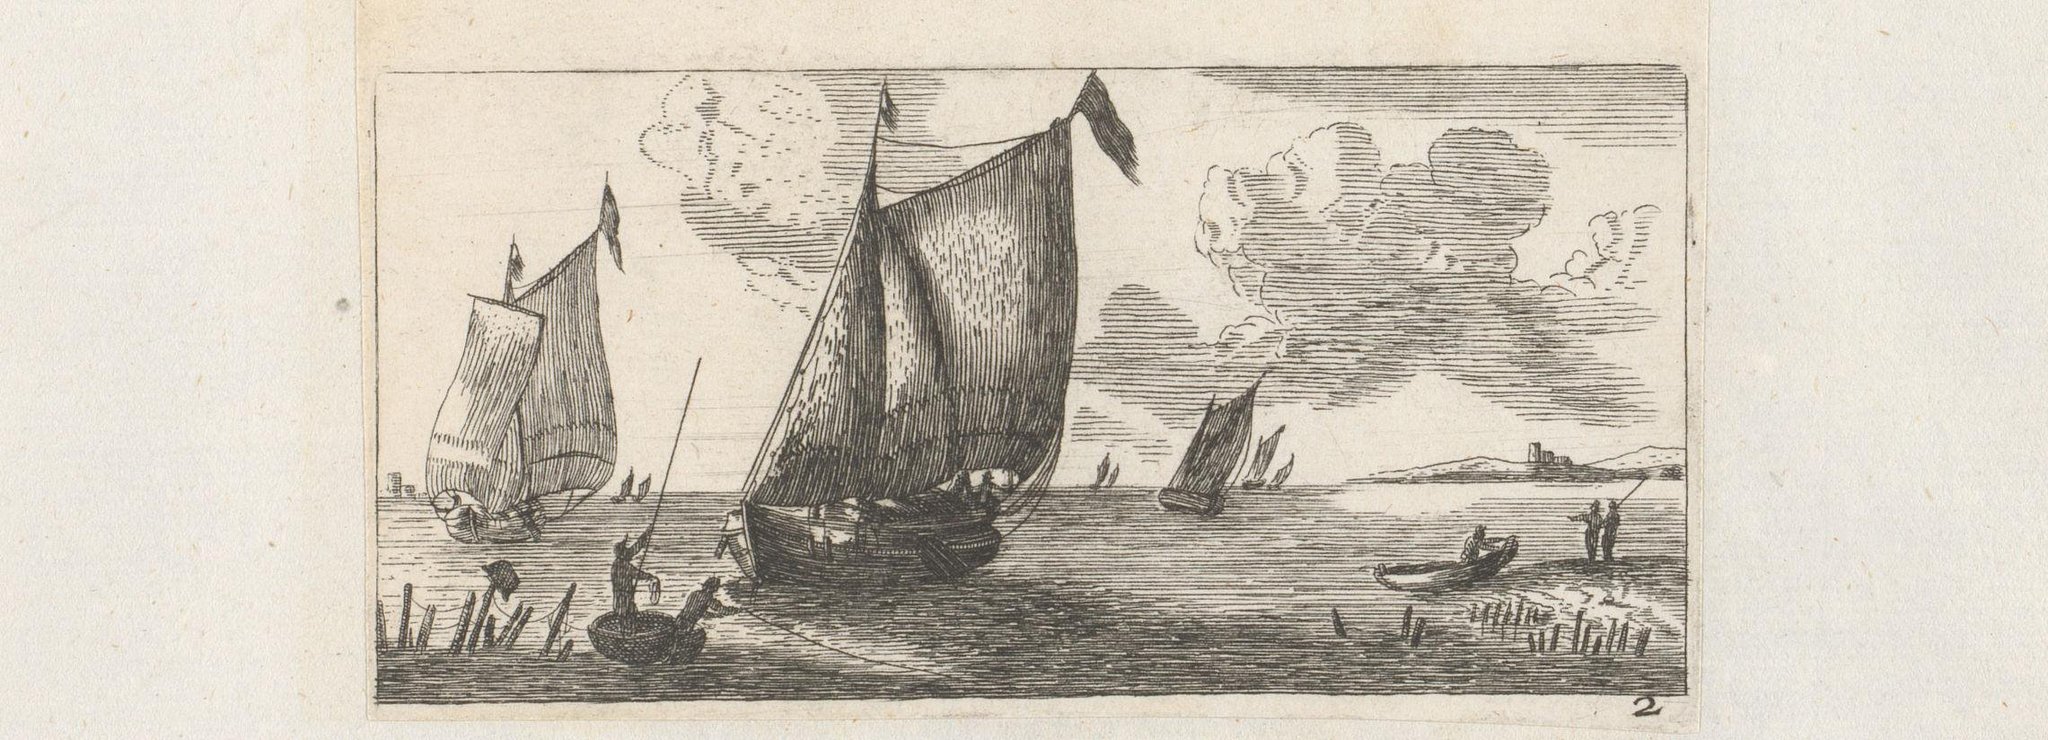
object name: print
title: Zeilschepen en vissers aan de kust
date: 1686-1724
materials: paper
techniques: etching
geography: augsburg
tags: sailing-ship, sailing-boat, coast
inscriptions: collector's mark: Lugt 2228, collector's mark: Lugt 2760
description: Prent uit een reeks met soortgelijke zeegezichten. Het is onbekend uit hoeveel prenten deze serie in totaal bestaat. Prent gedrukt op één blad met RP-P-1964-1988.